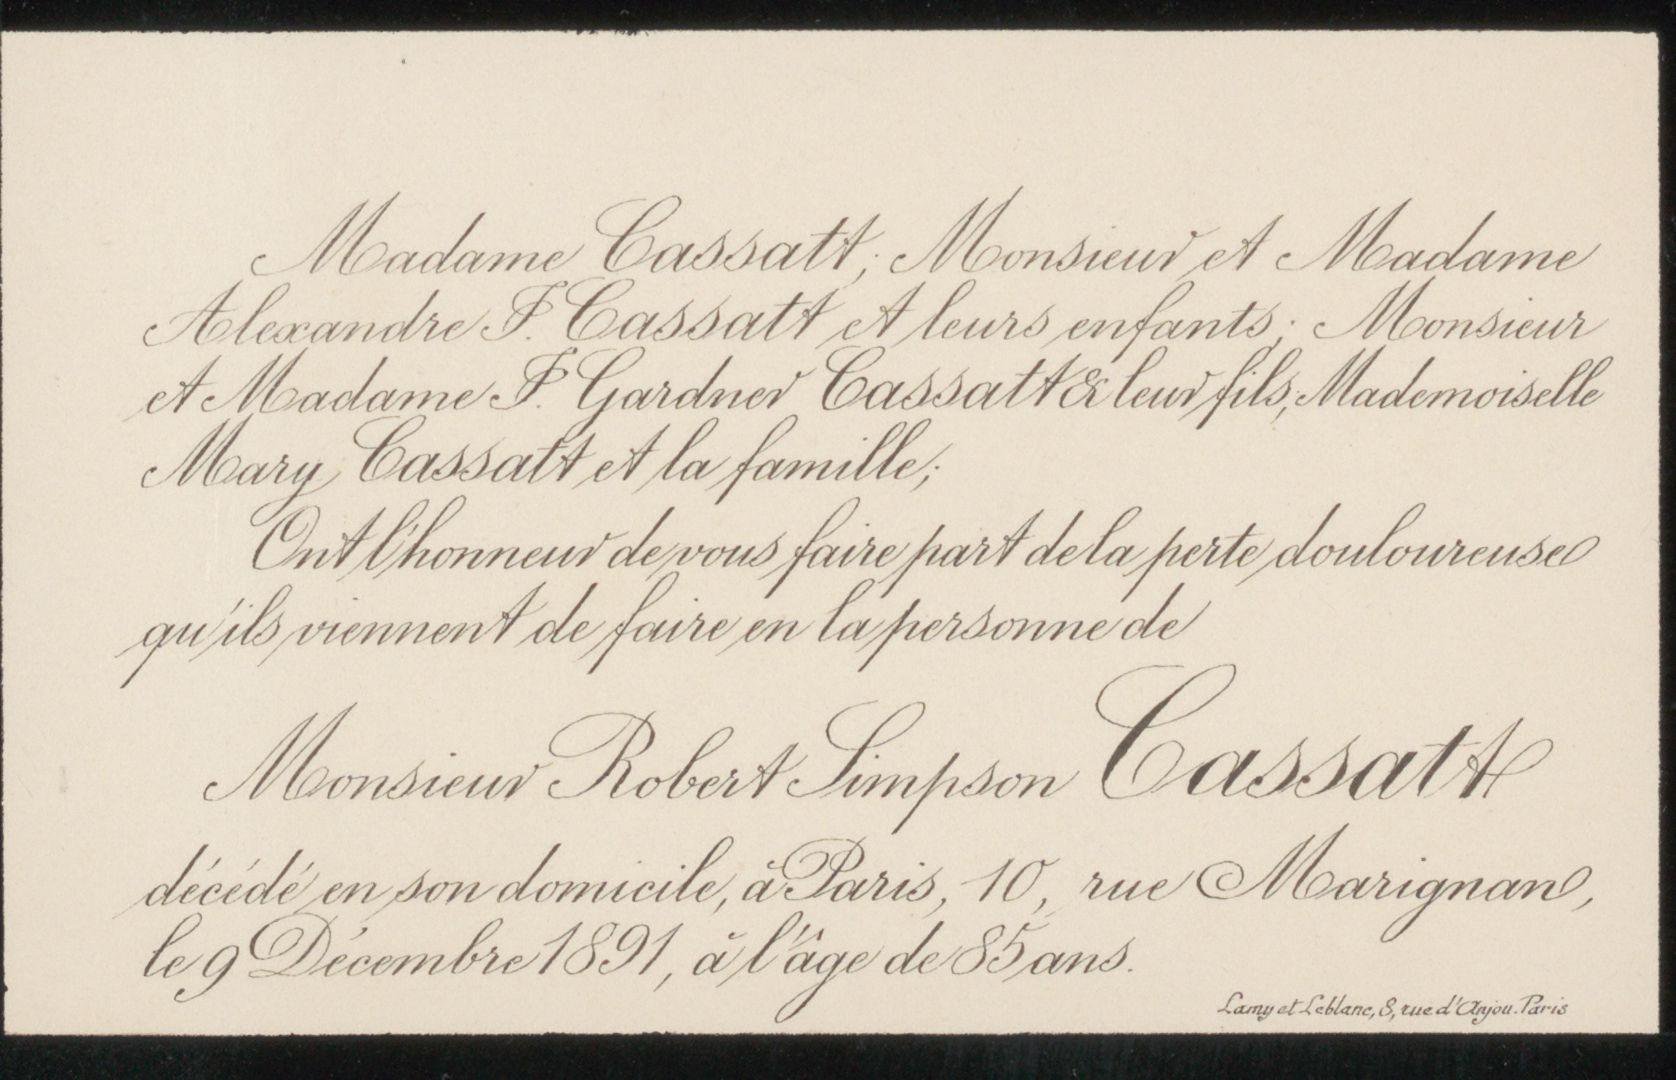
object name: overlijdensbericht, overlijdensadvertentie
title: Overlijdensbericht aan Philip Zilcken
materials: paper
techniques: printing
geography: paris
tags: paris, the hague, painter, draughtsman, philip zilcken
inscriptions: collector's mark: ‘RPK’